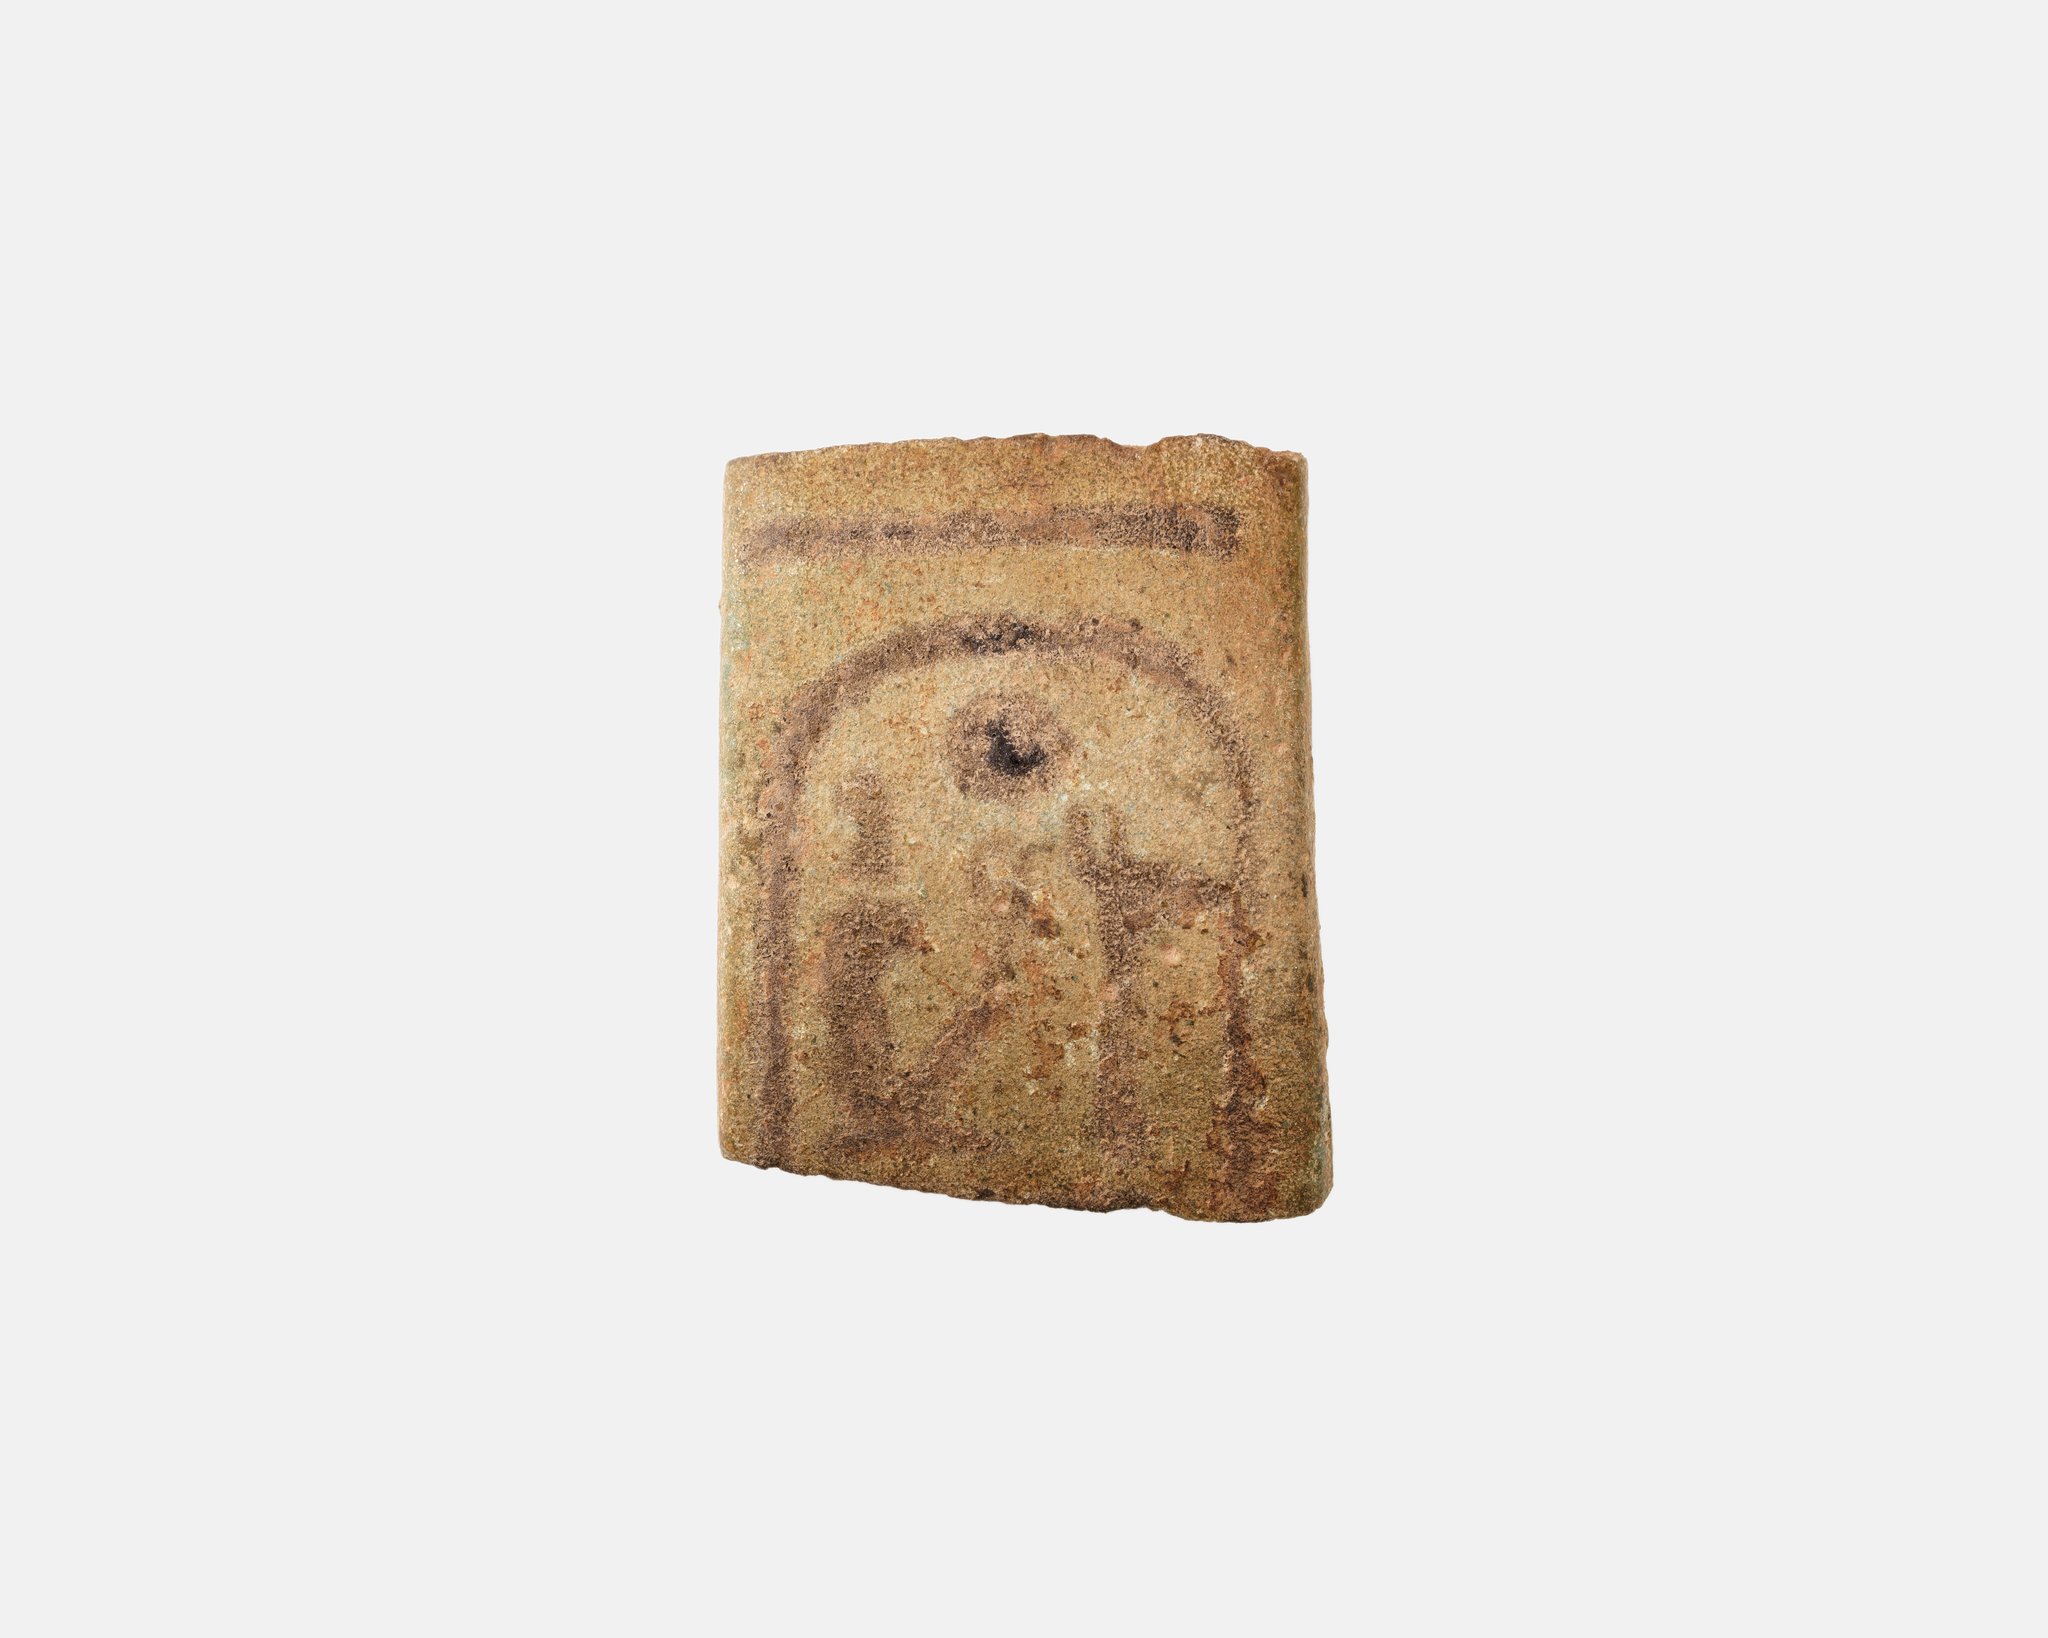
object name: votive bracelet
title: Fragment of a votive bracelet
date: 1295-1070 BCE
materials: faience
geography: egypt